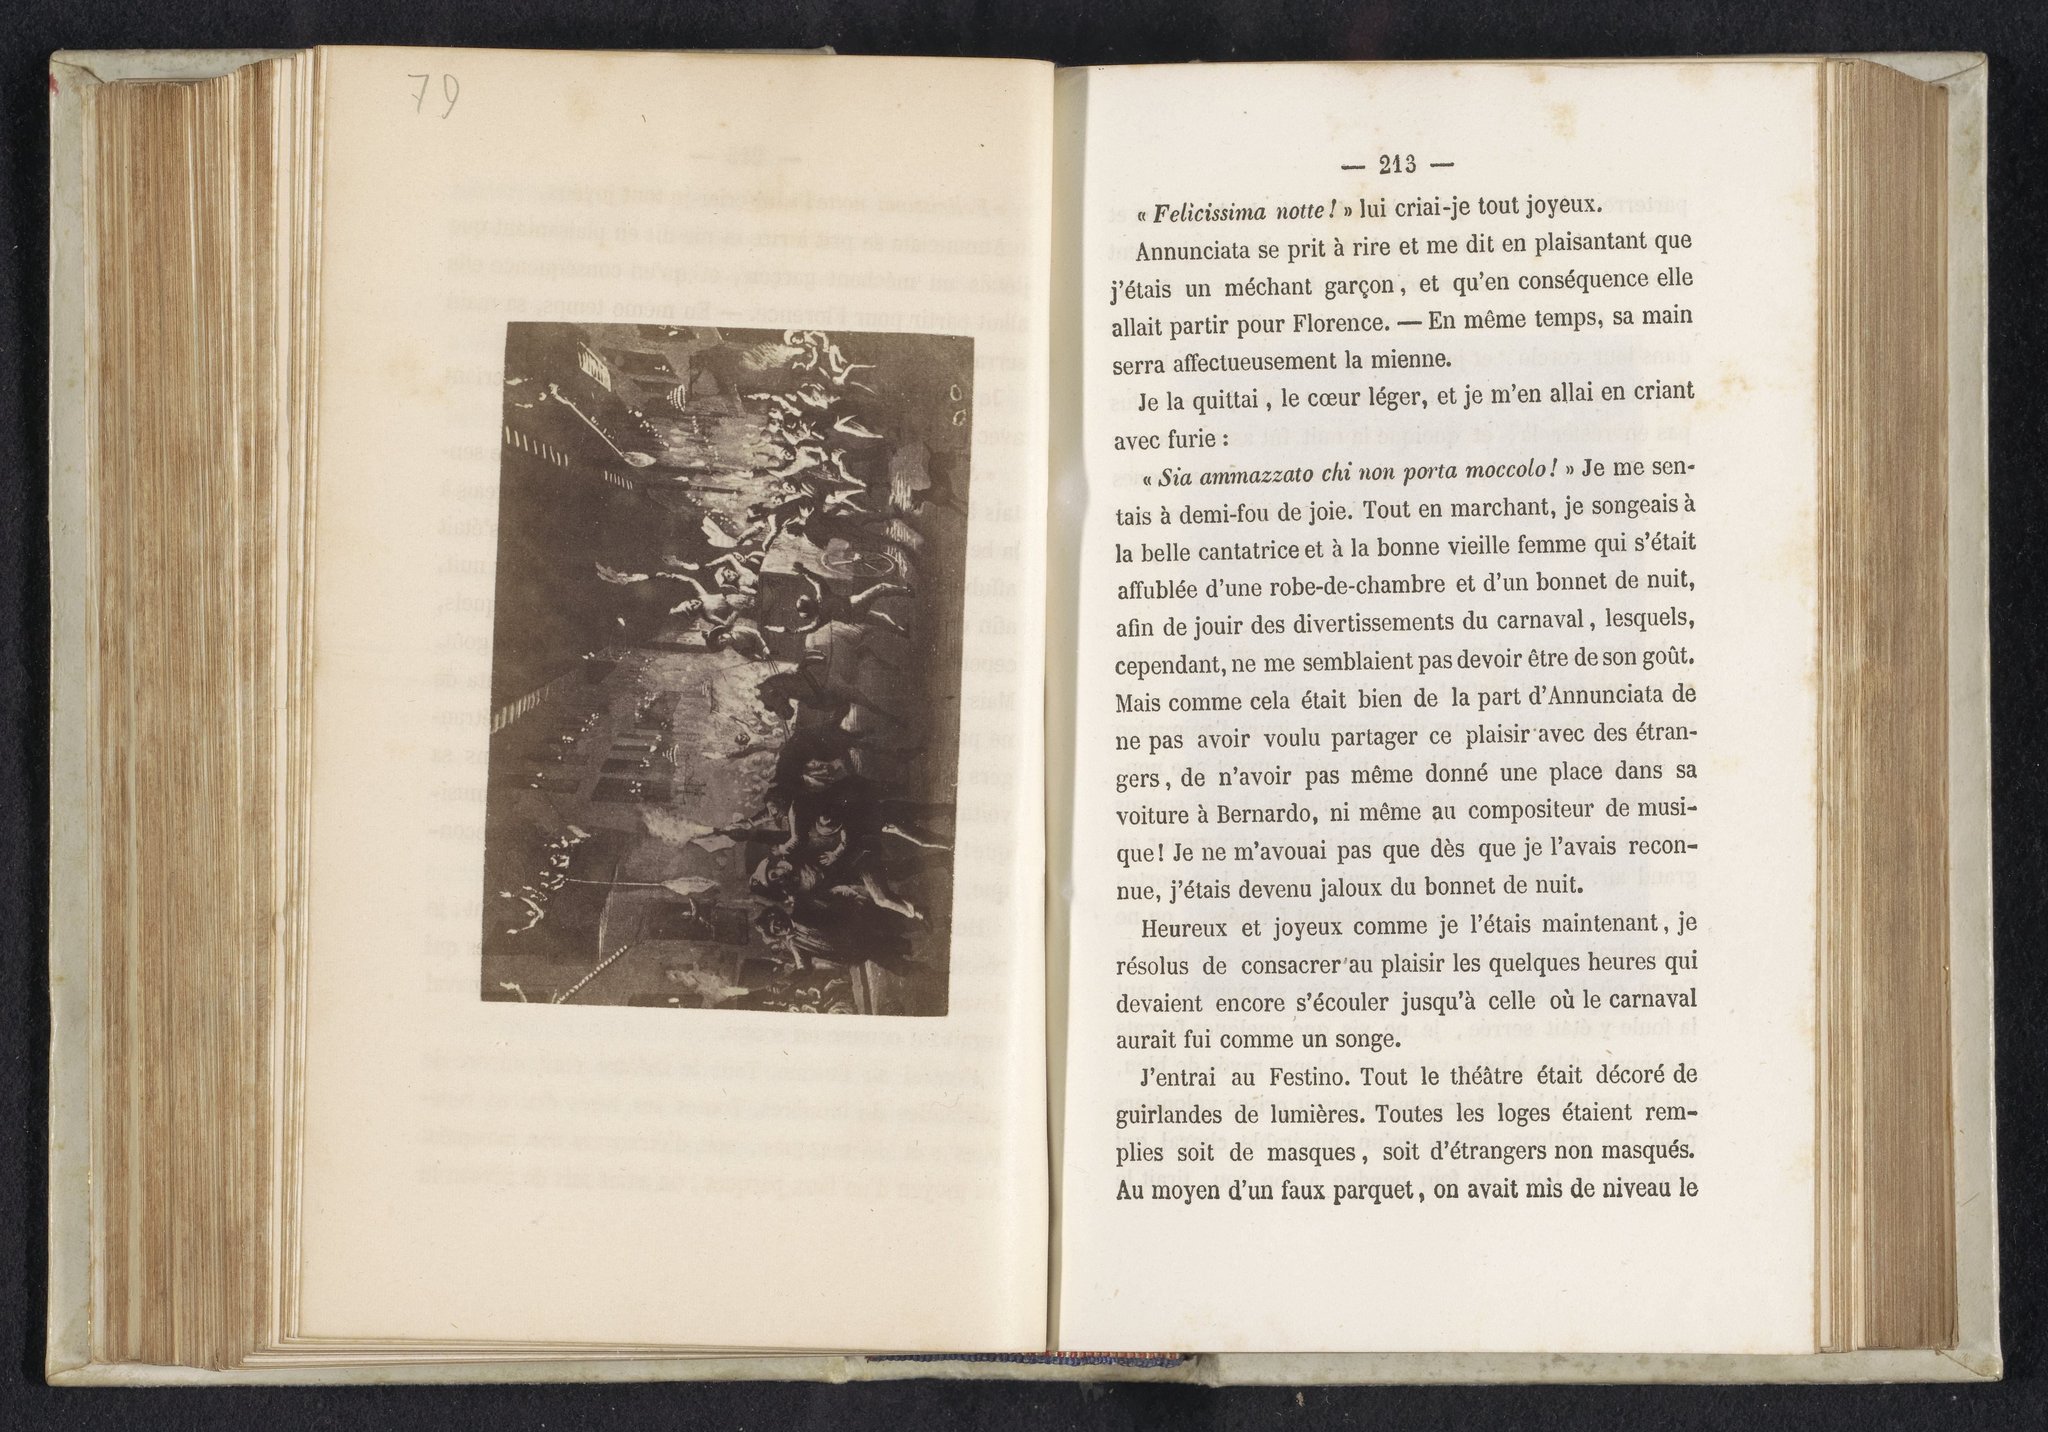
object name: page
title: Fotoreproductie van een schilderij, voorstellende een feestvierende menigte met fakkels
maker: Anonymous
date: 1850-1860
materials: photographic support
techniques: albumen print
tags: crowd, mob, torch, festivities